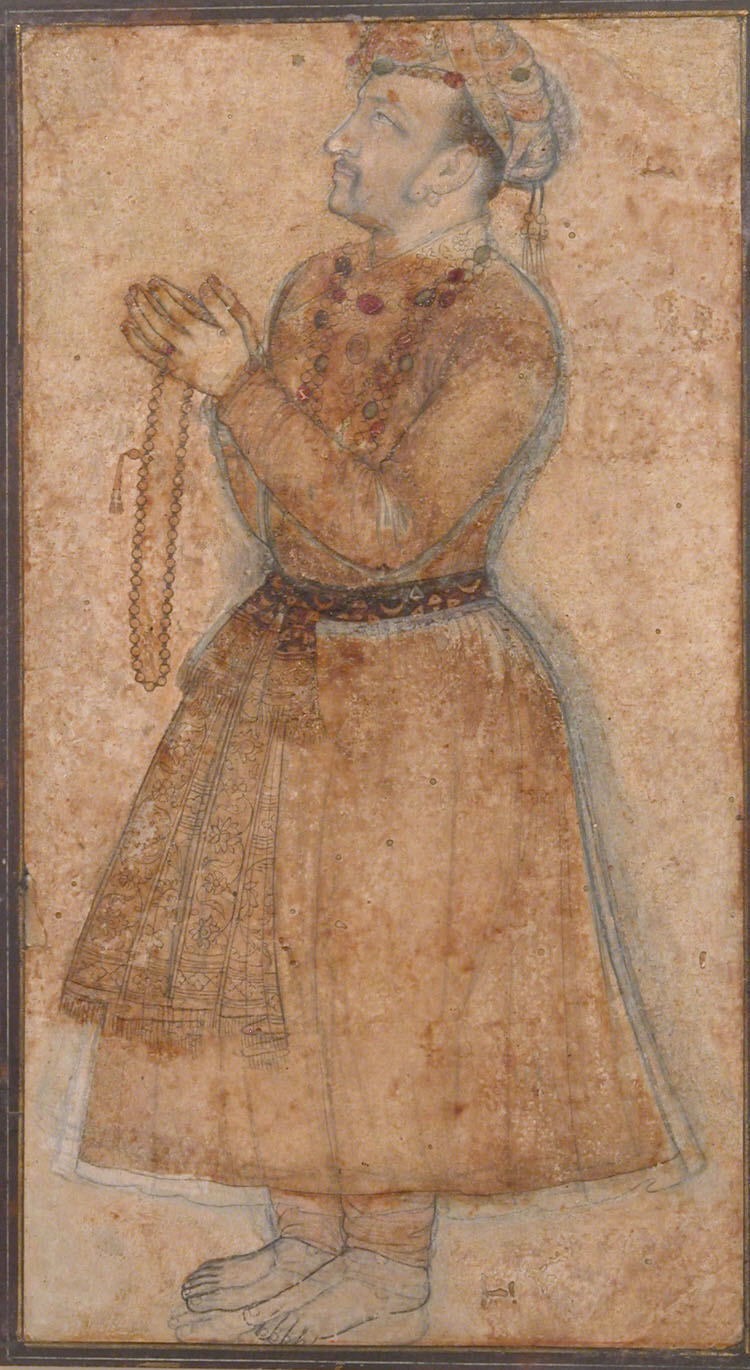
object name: illustrated single work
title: Portrait of Emperor Jahangir Praying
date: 1601-1633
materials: ink, paper, watercolor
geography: india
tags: men,praying